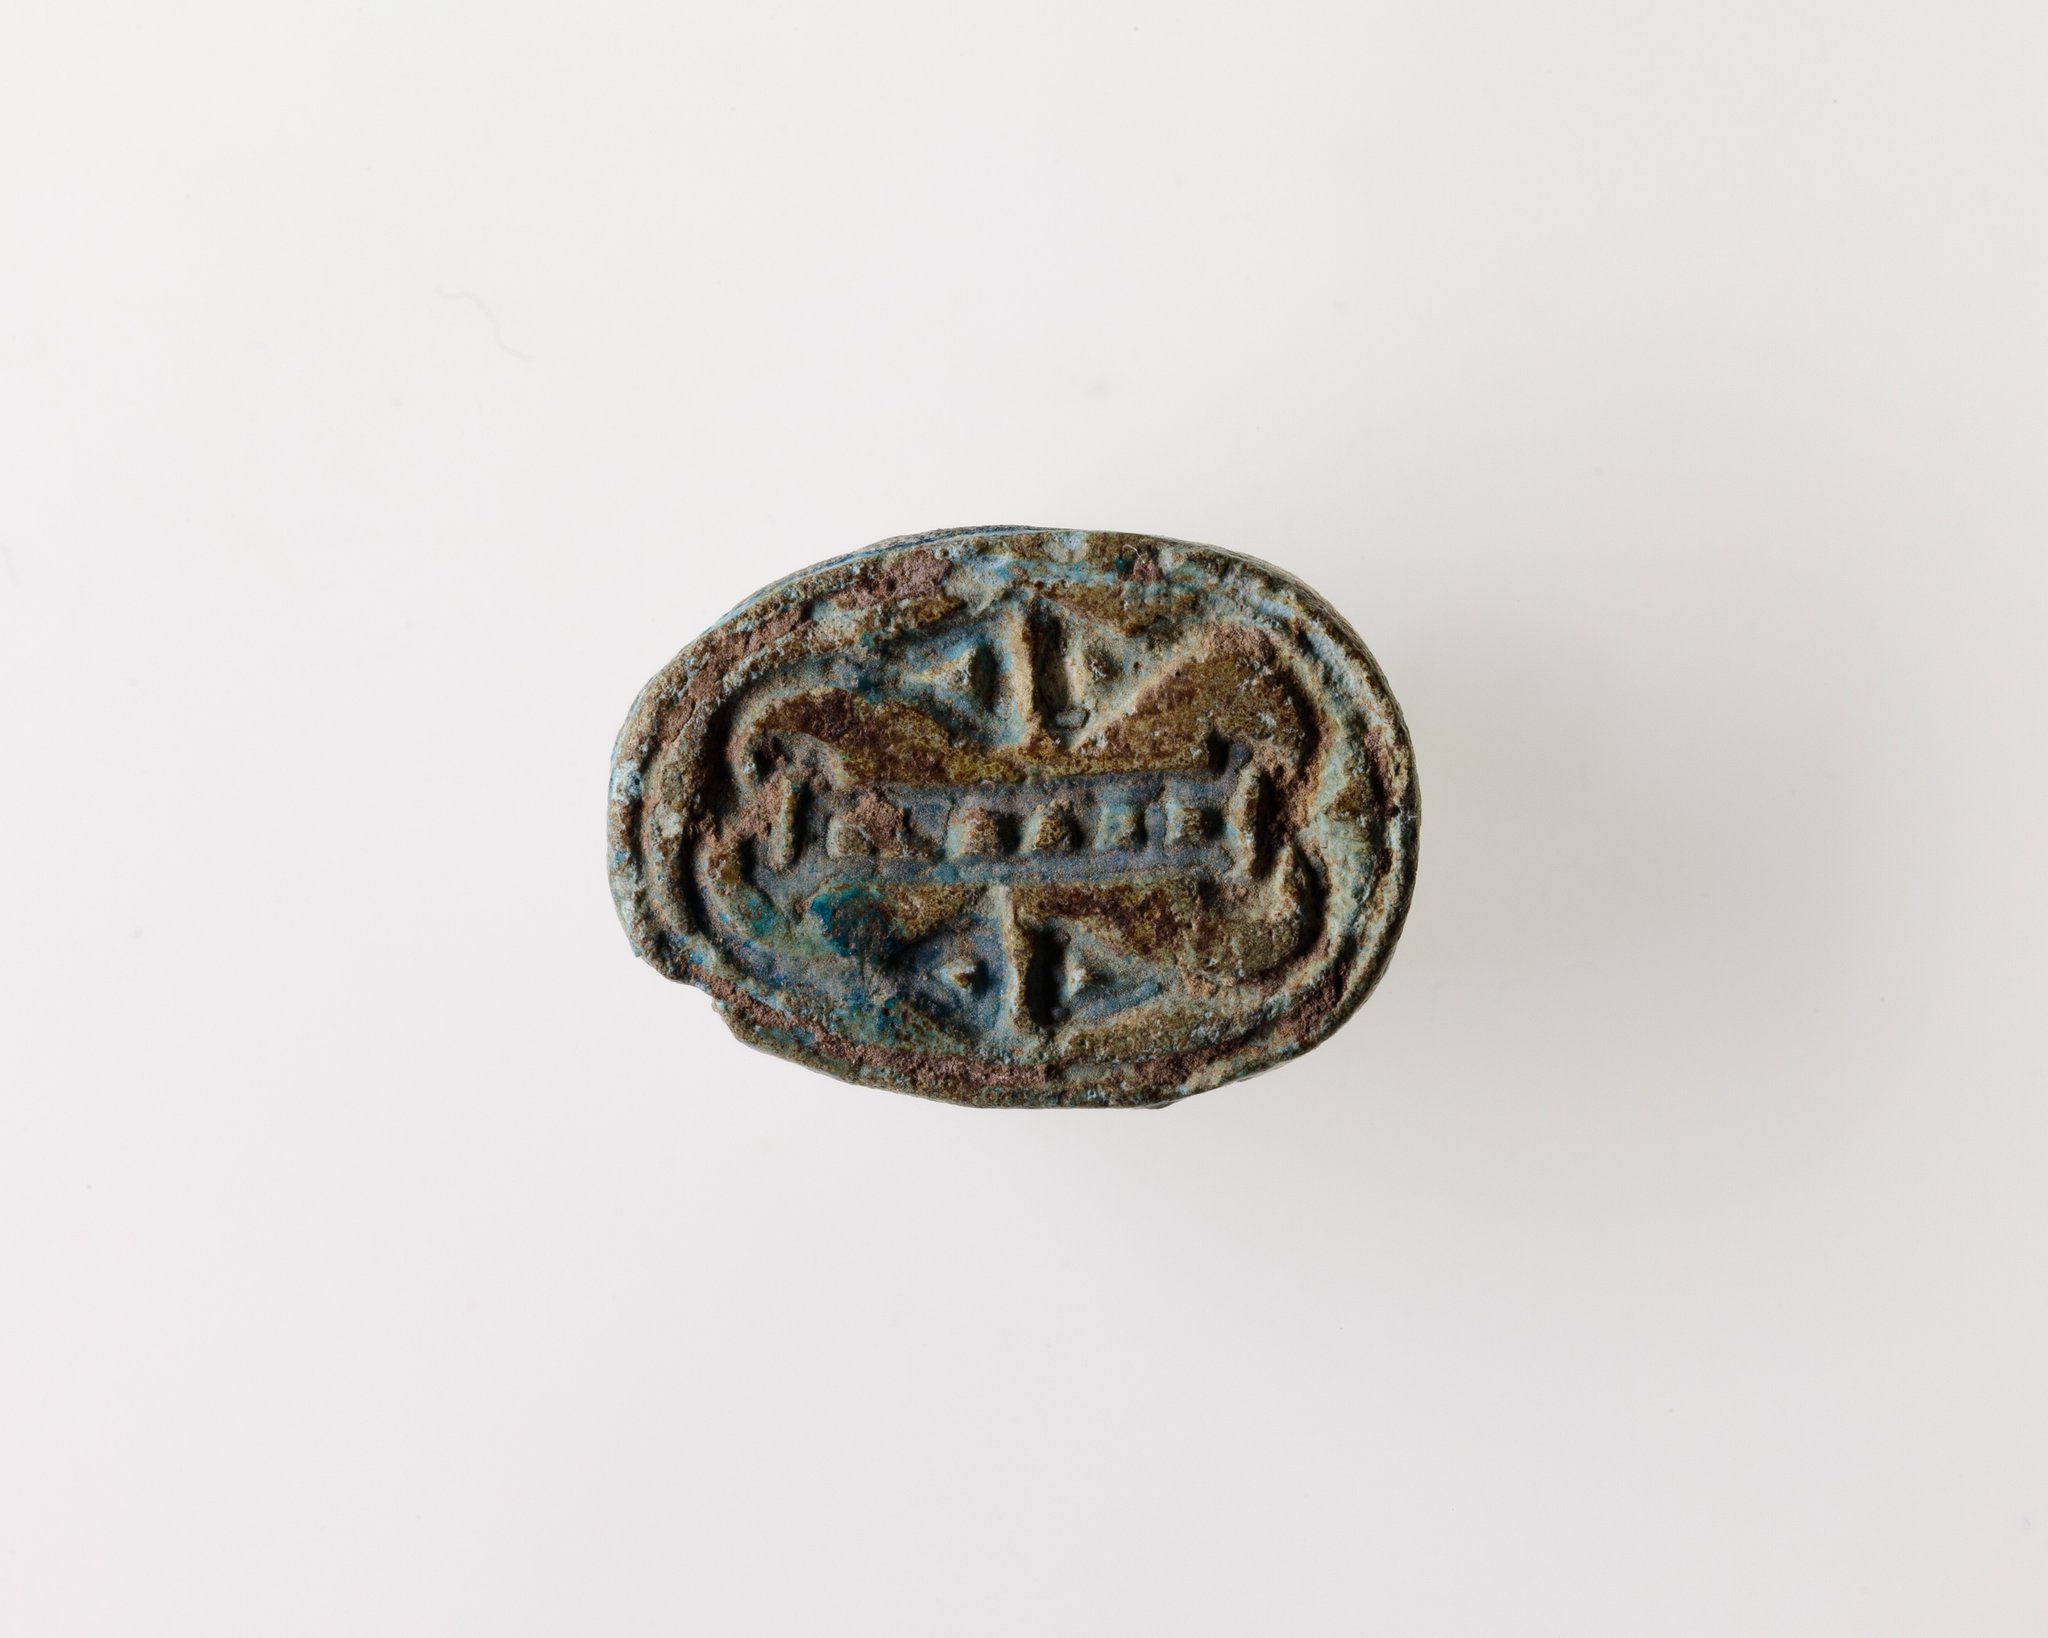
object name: scarab, papyrus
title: Scarab with Plant Motif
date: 1850-1640 BCE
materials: faience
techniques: glazing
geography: egypt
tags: hieroglyphs,scarabs